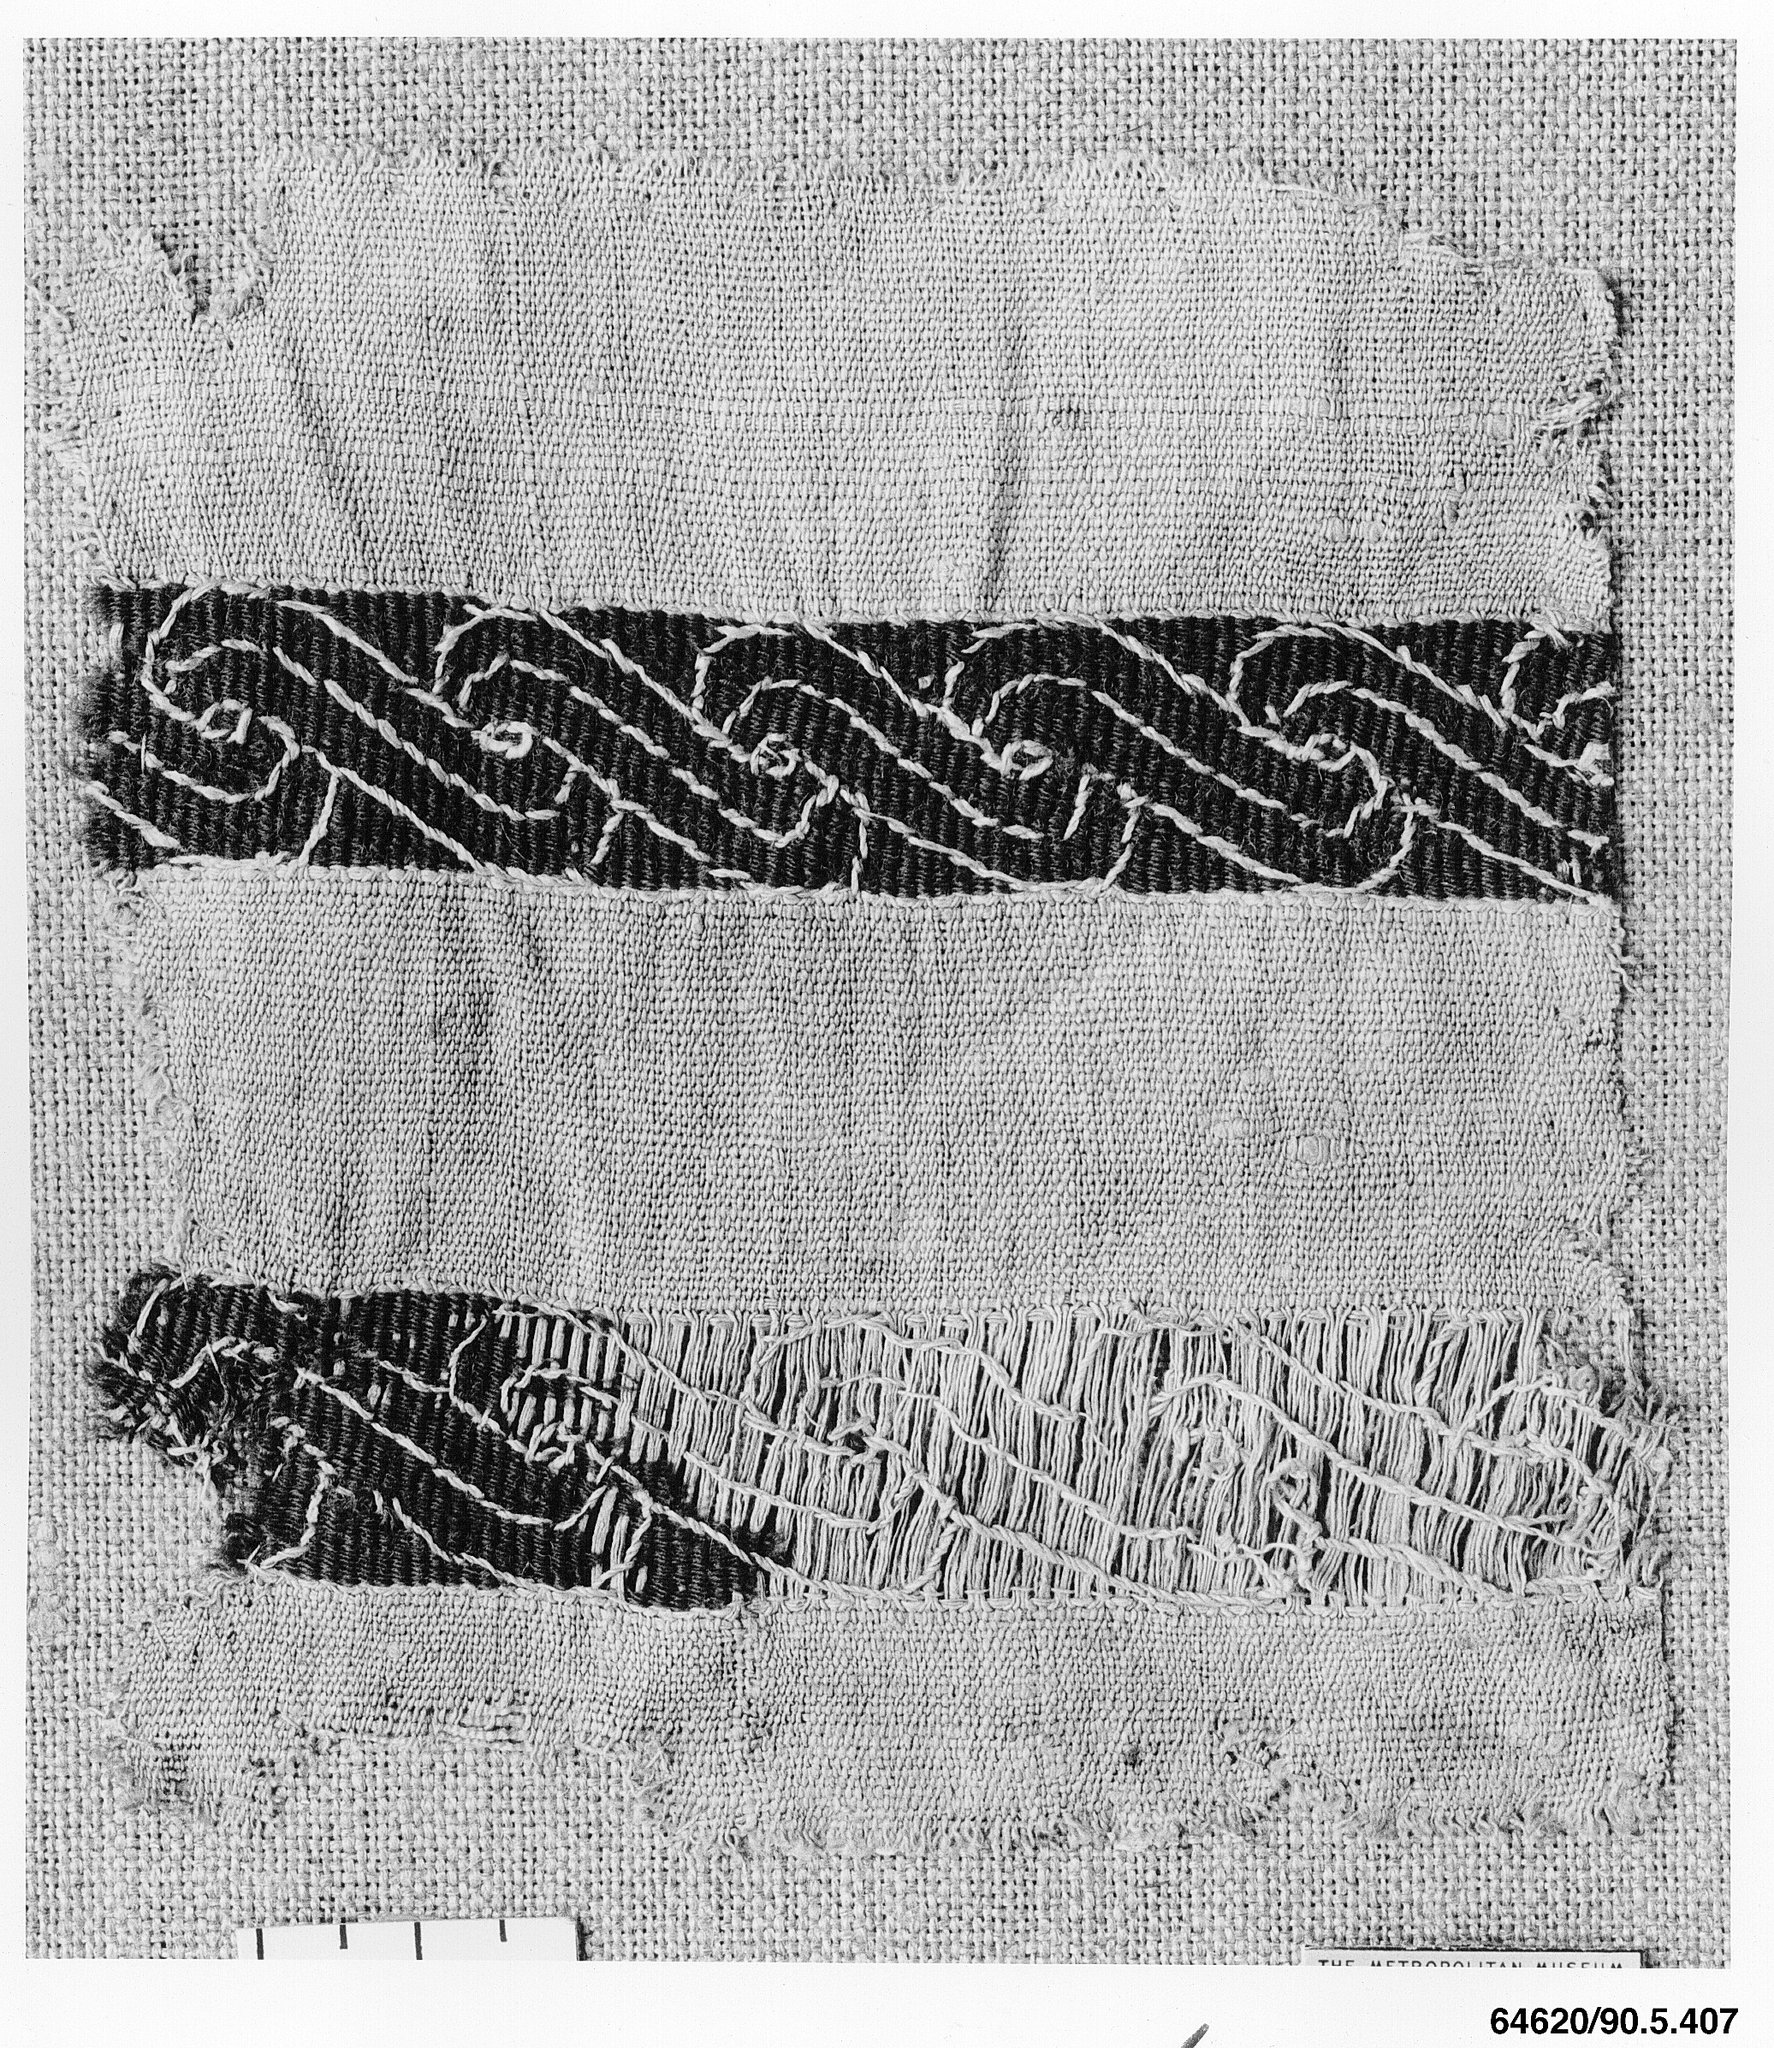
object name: textile fragment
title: Fragment of a Sleeve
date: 201-400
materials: linen, wool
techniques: weave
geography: egypt